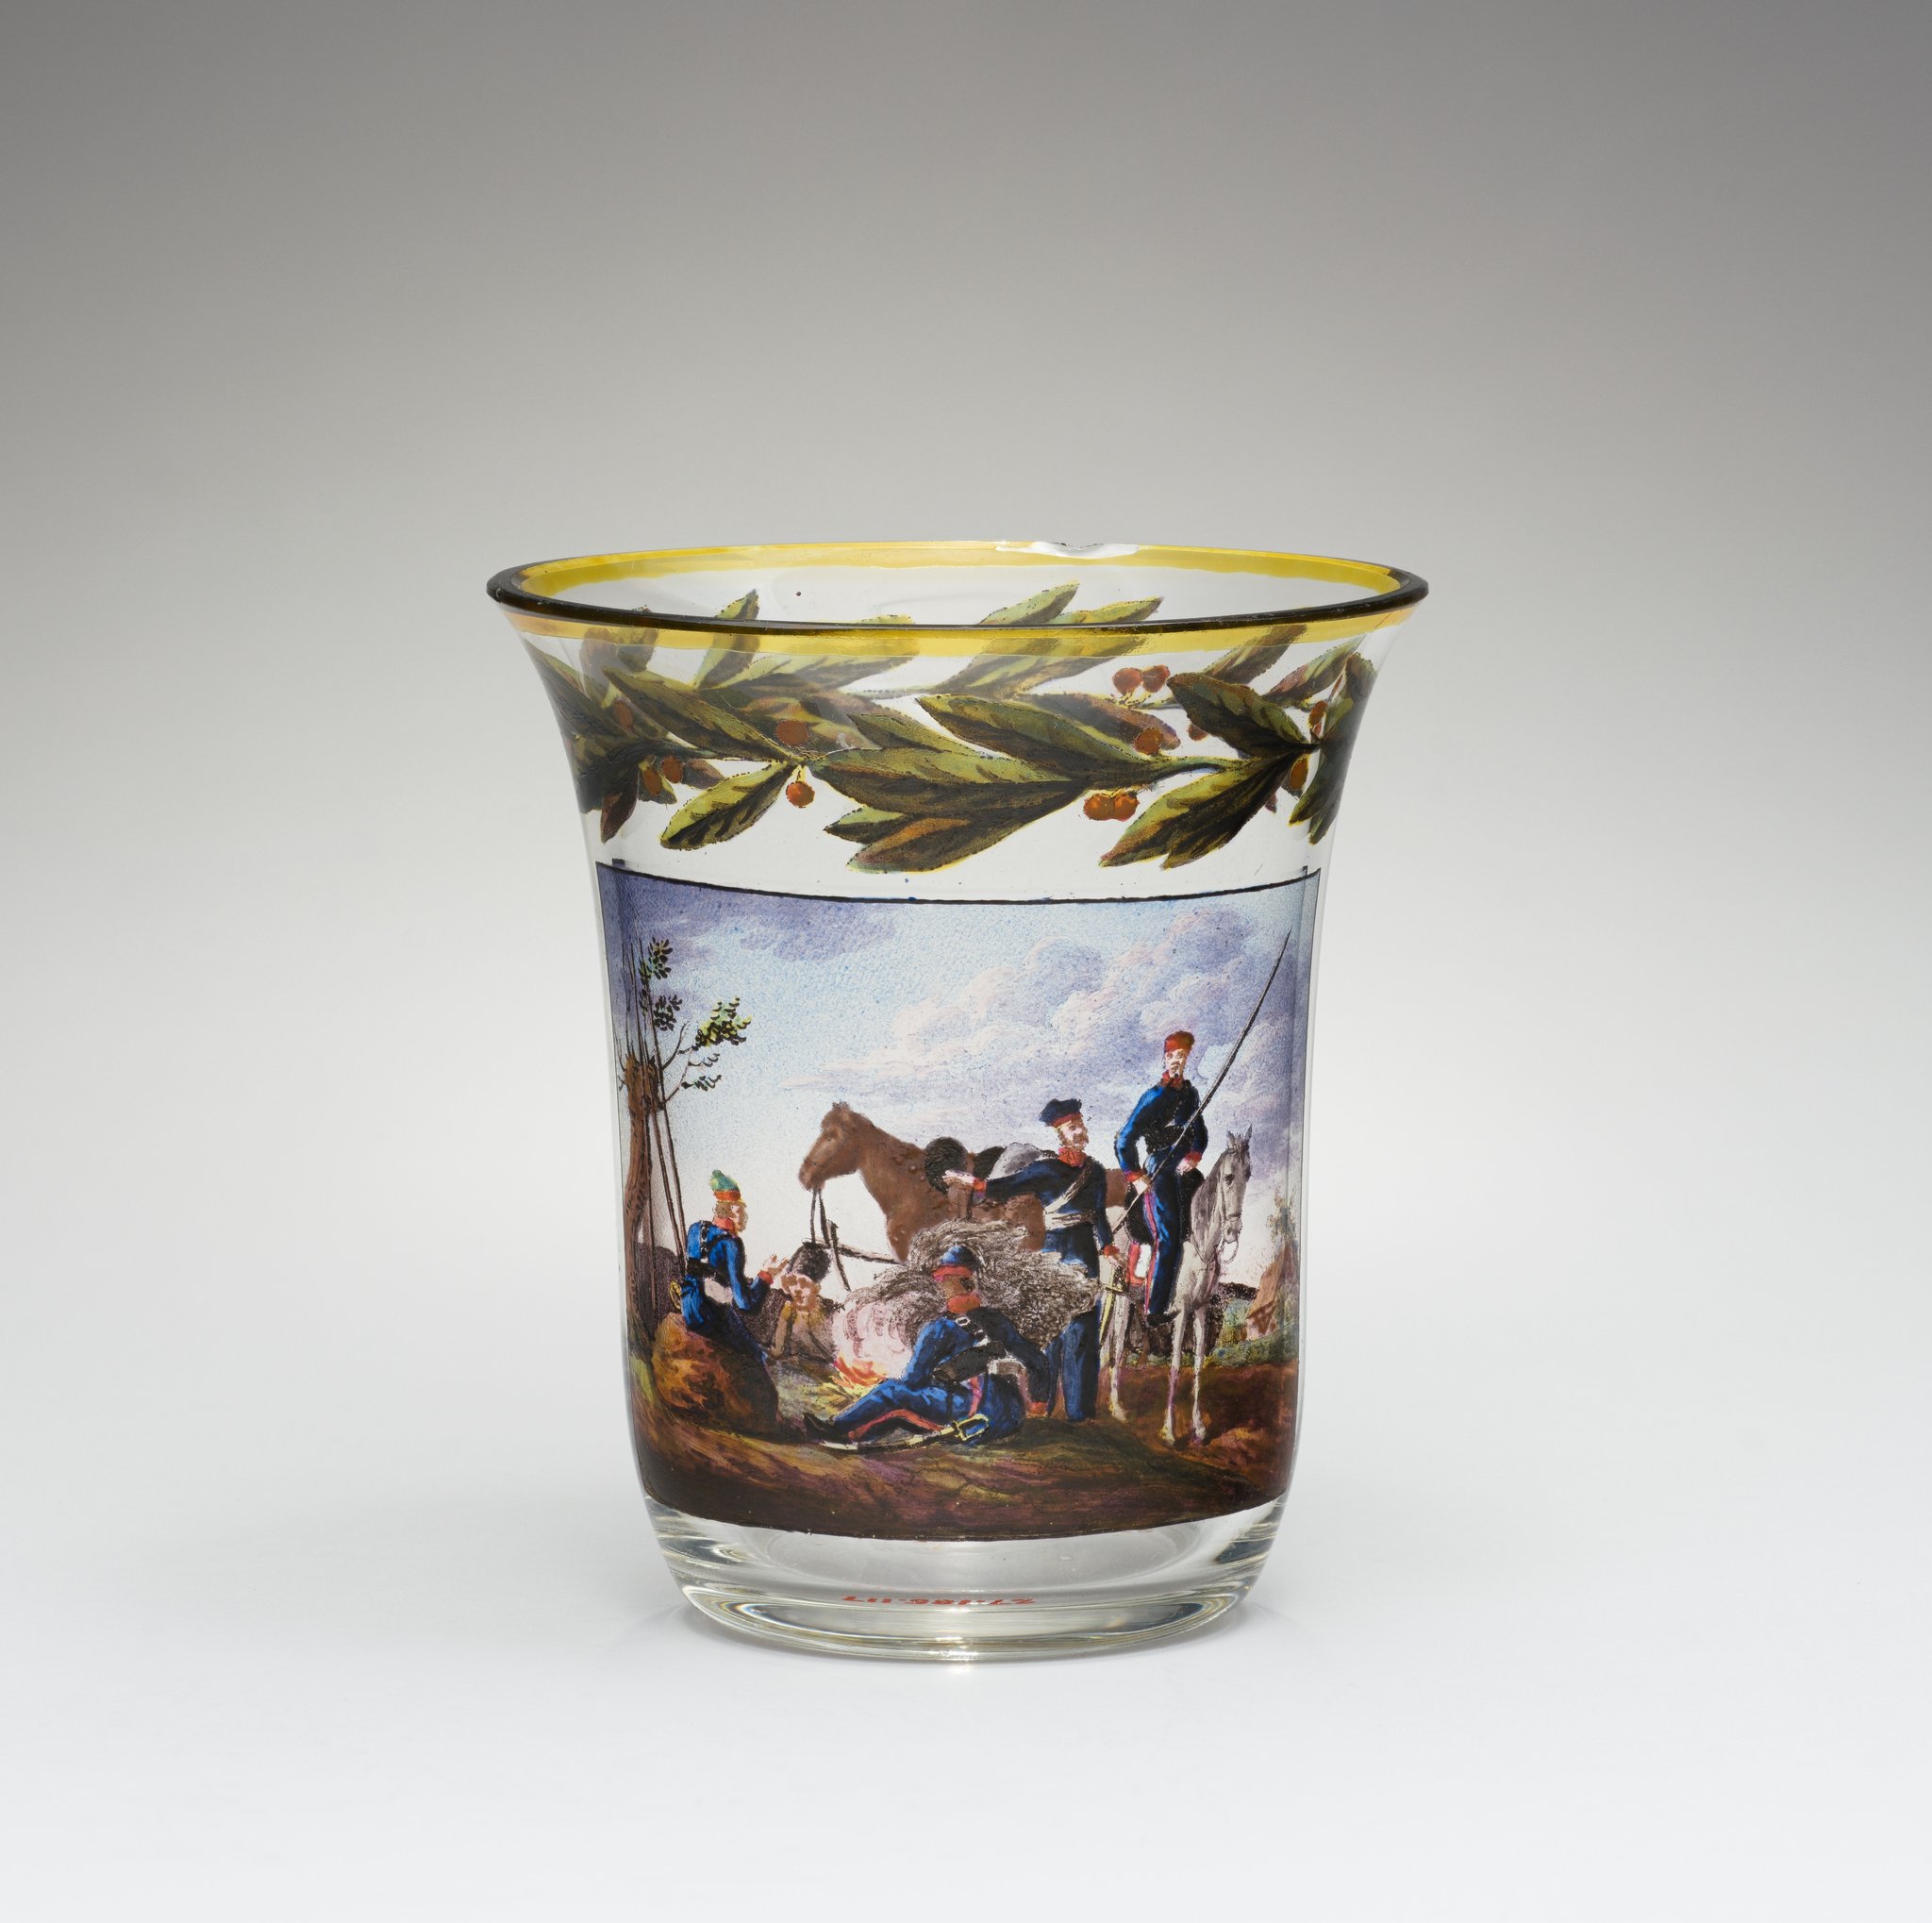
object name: beaker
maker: gottlob samuel mohn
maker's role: decorator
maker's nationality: austrian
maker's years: 1789-1825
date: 1815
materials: glass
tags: soldiers,men,horses